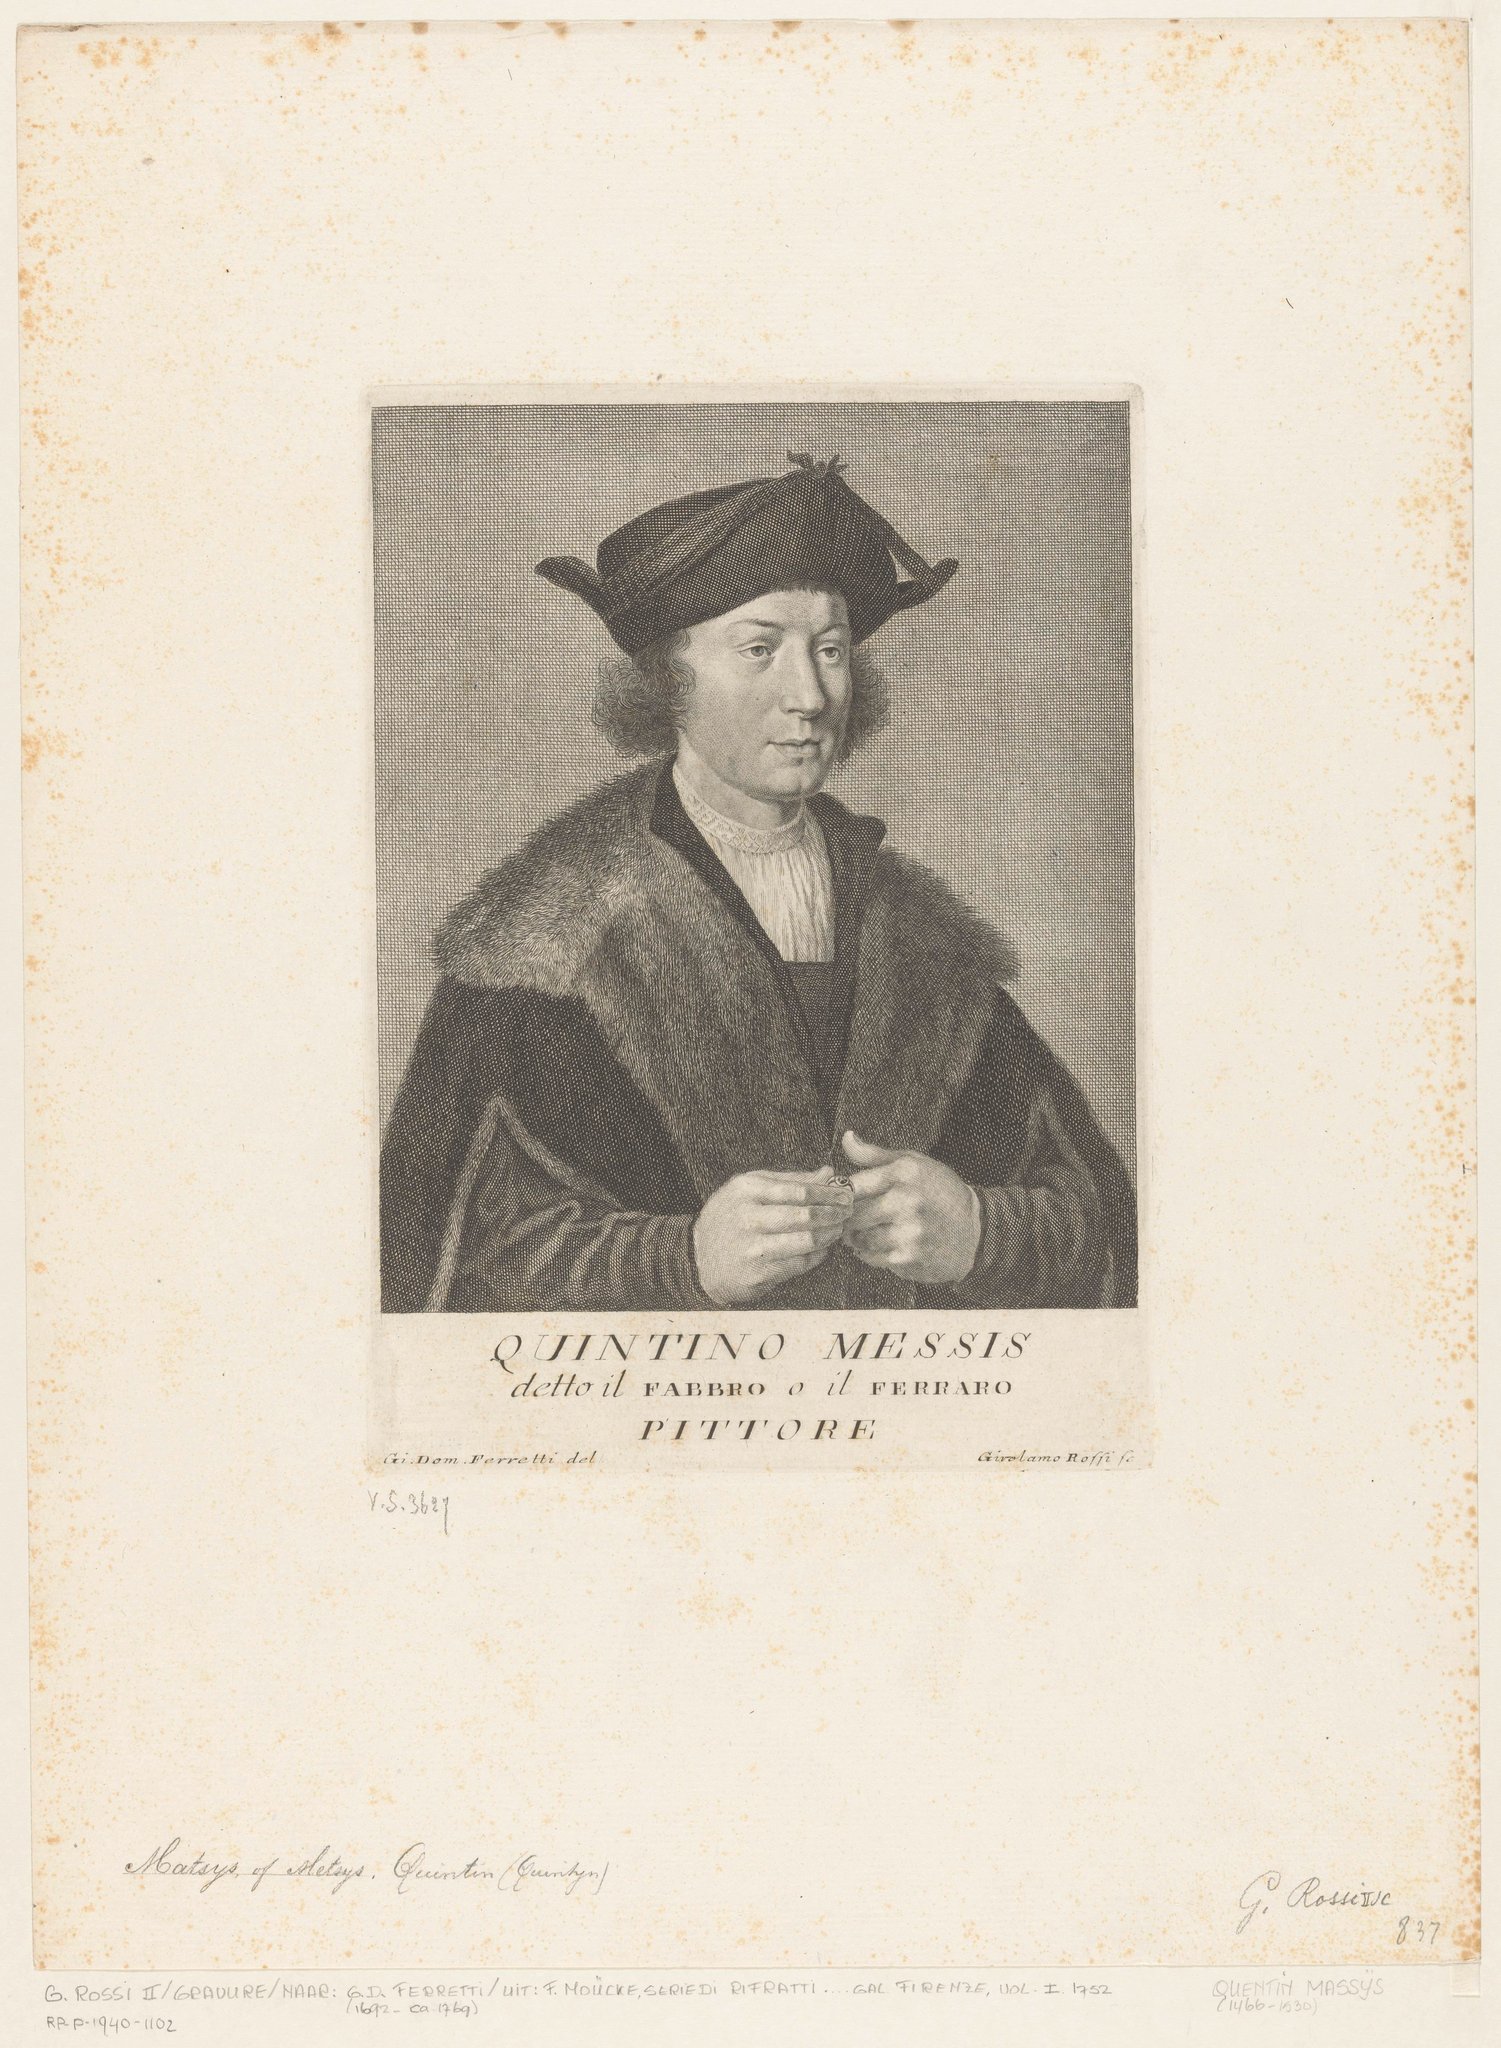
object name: book illustration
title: Portret van kunstenaar Quinten Massijs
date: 1752-1762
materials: paper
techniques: etching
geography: italy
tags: louvain, antwerp, draughtsman, quinten massijs (i), historical persons, portrait, self-portrait of artist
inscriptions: collector's mark: Lugt 2760, collector's mark: Lugt 2166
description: Prent uit: Moücke, Francesco. Serie di ritratti degli eccellenti pittori dipinti di propria mano, che esistono nell'Imiperial Galleria di Firenze. Florence: 1752-1762.